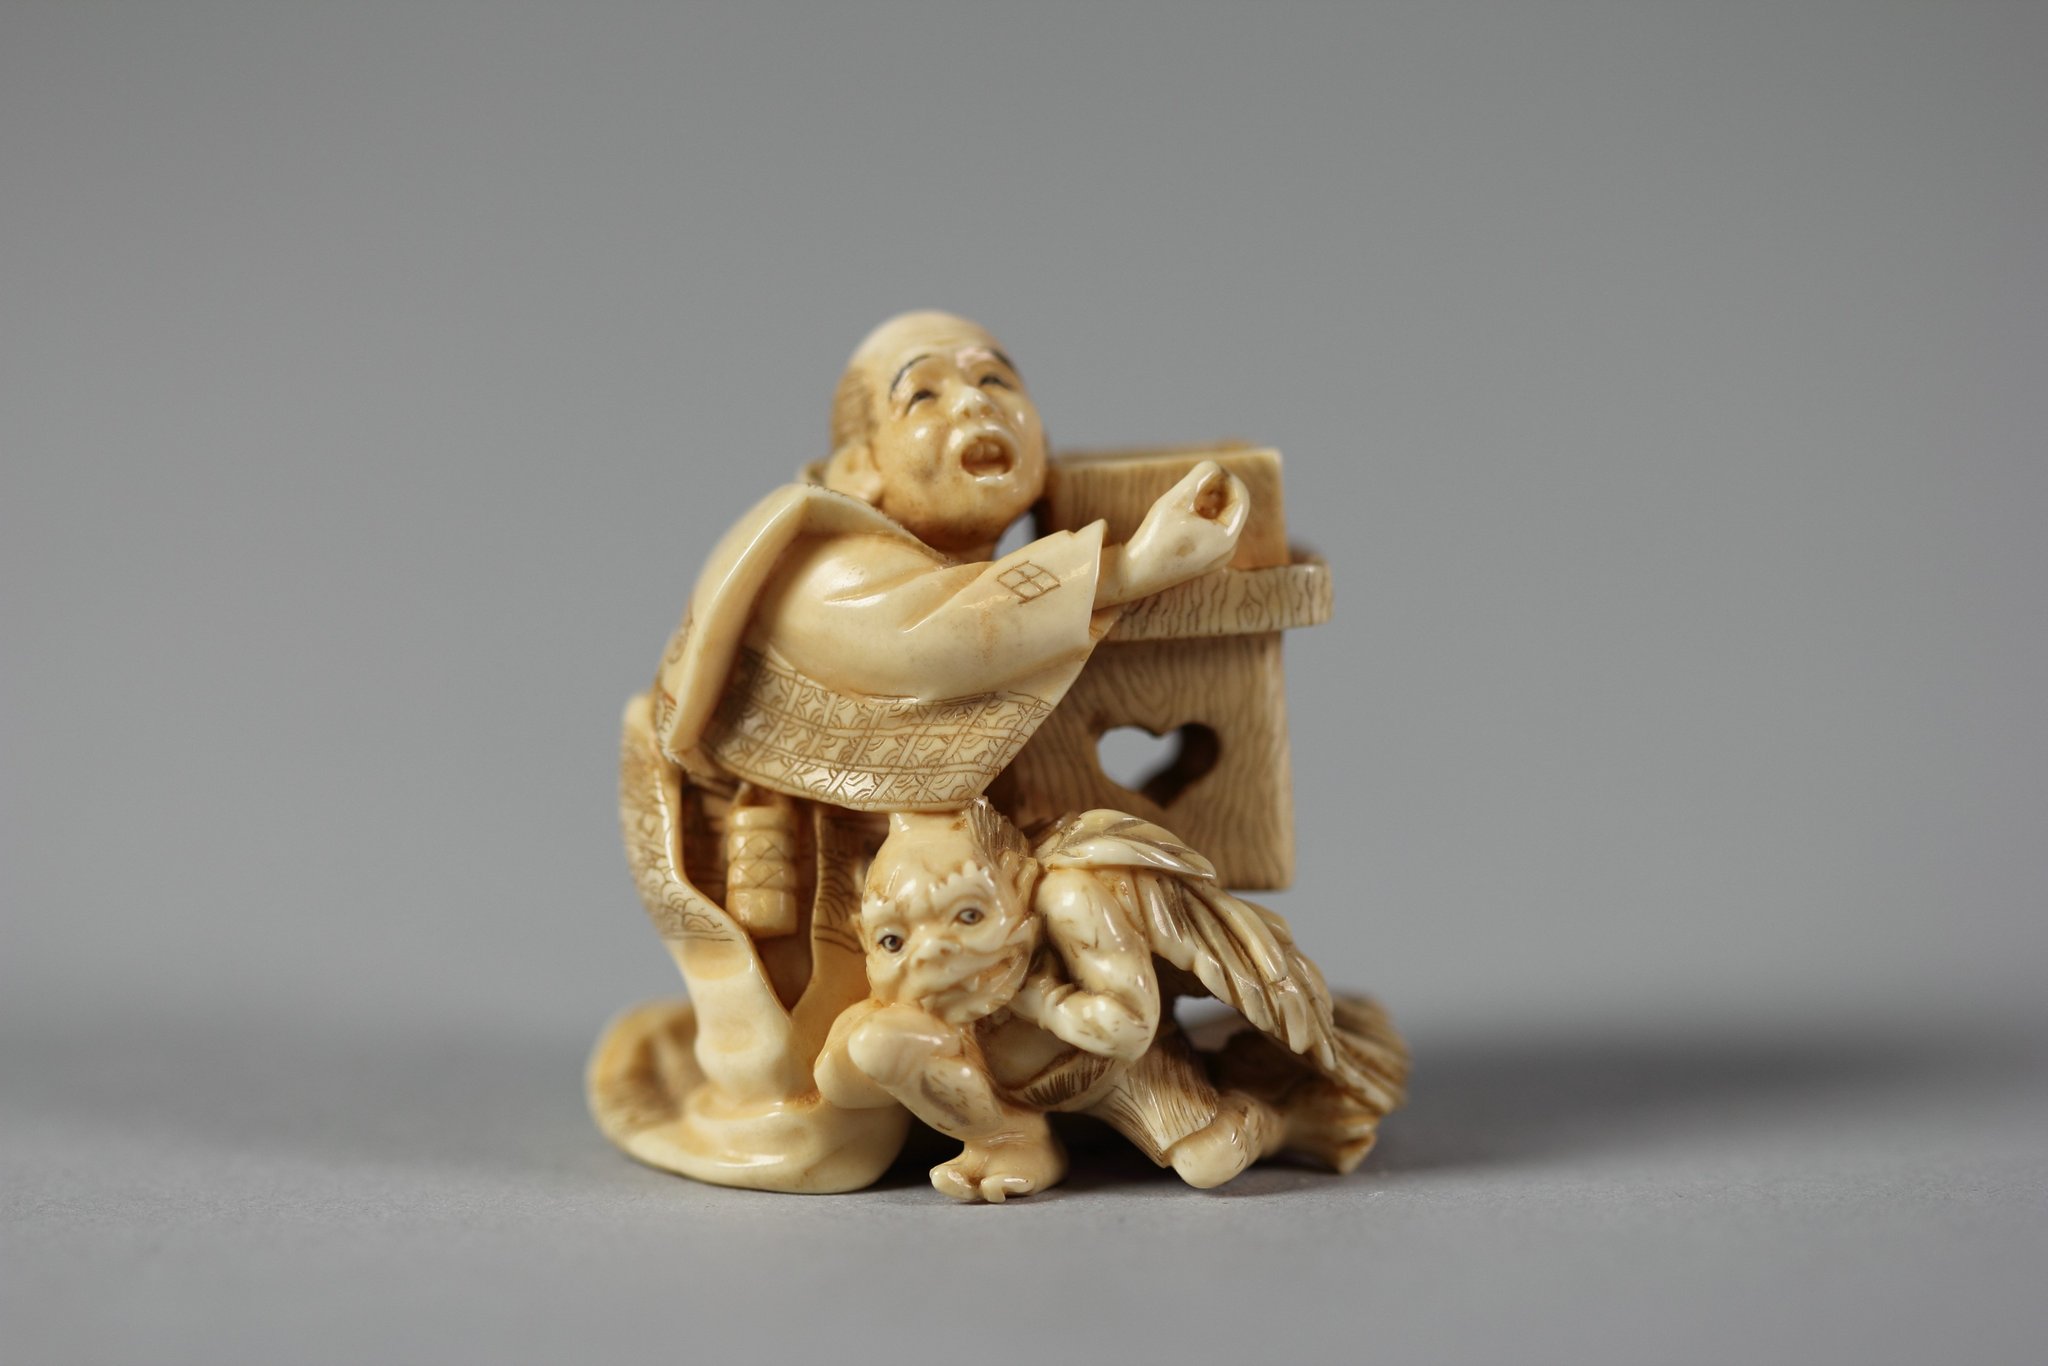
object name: netsuke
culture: japanese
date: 1801-1900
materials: ivory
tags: mythical creatures